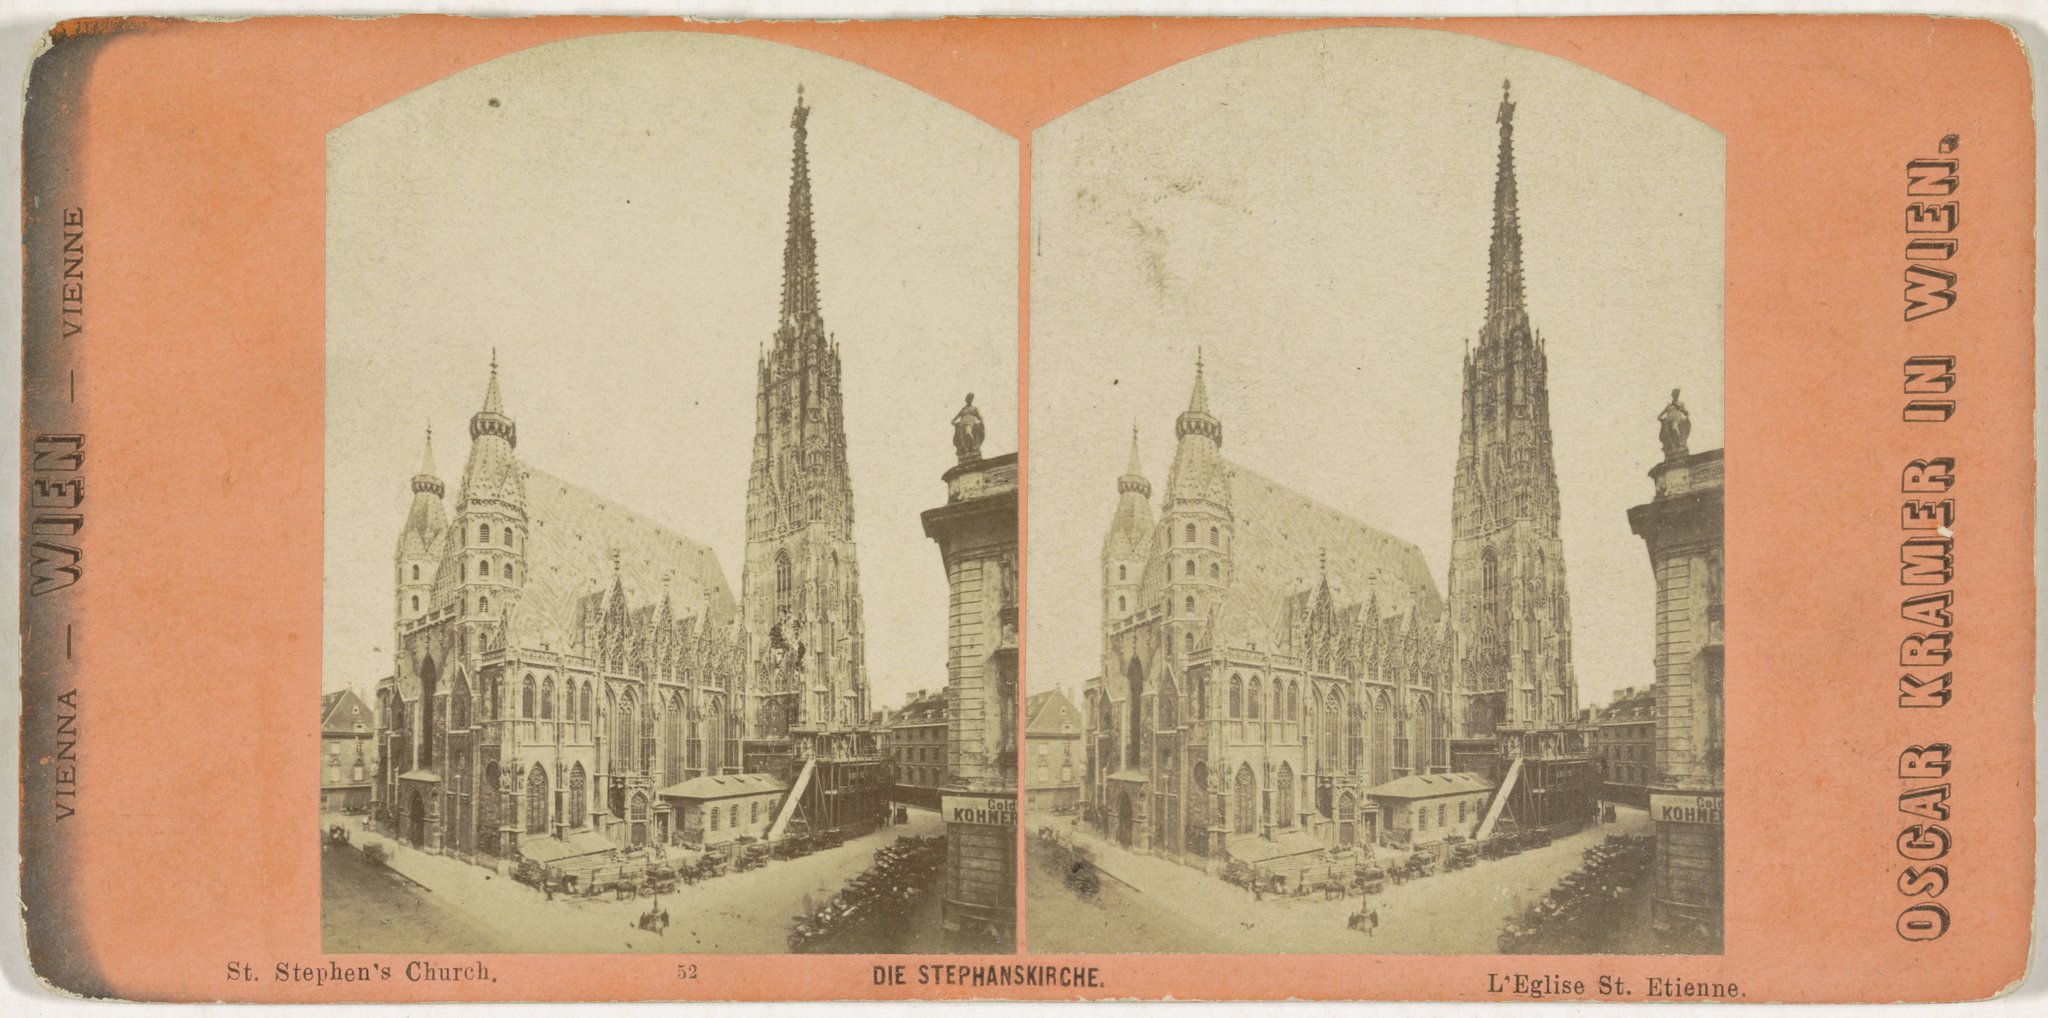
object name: stereograph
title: St. Stephen's Church. Die Stephanskirche. L'Eglise St. Etienne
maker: oscar krämer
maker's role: publisher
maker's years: 1835-1892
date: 1871-1877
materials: cardboard, paper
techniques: albumen print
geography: vienna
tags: church (exterior)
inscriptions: number: ‘52’, inscription: ‘Vervielfältigung vorbehalten.’